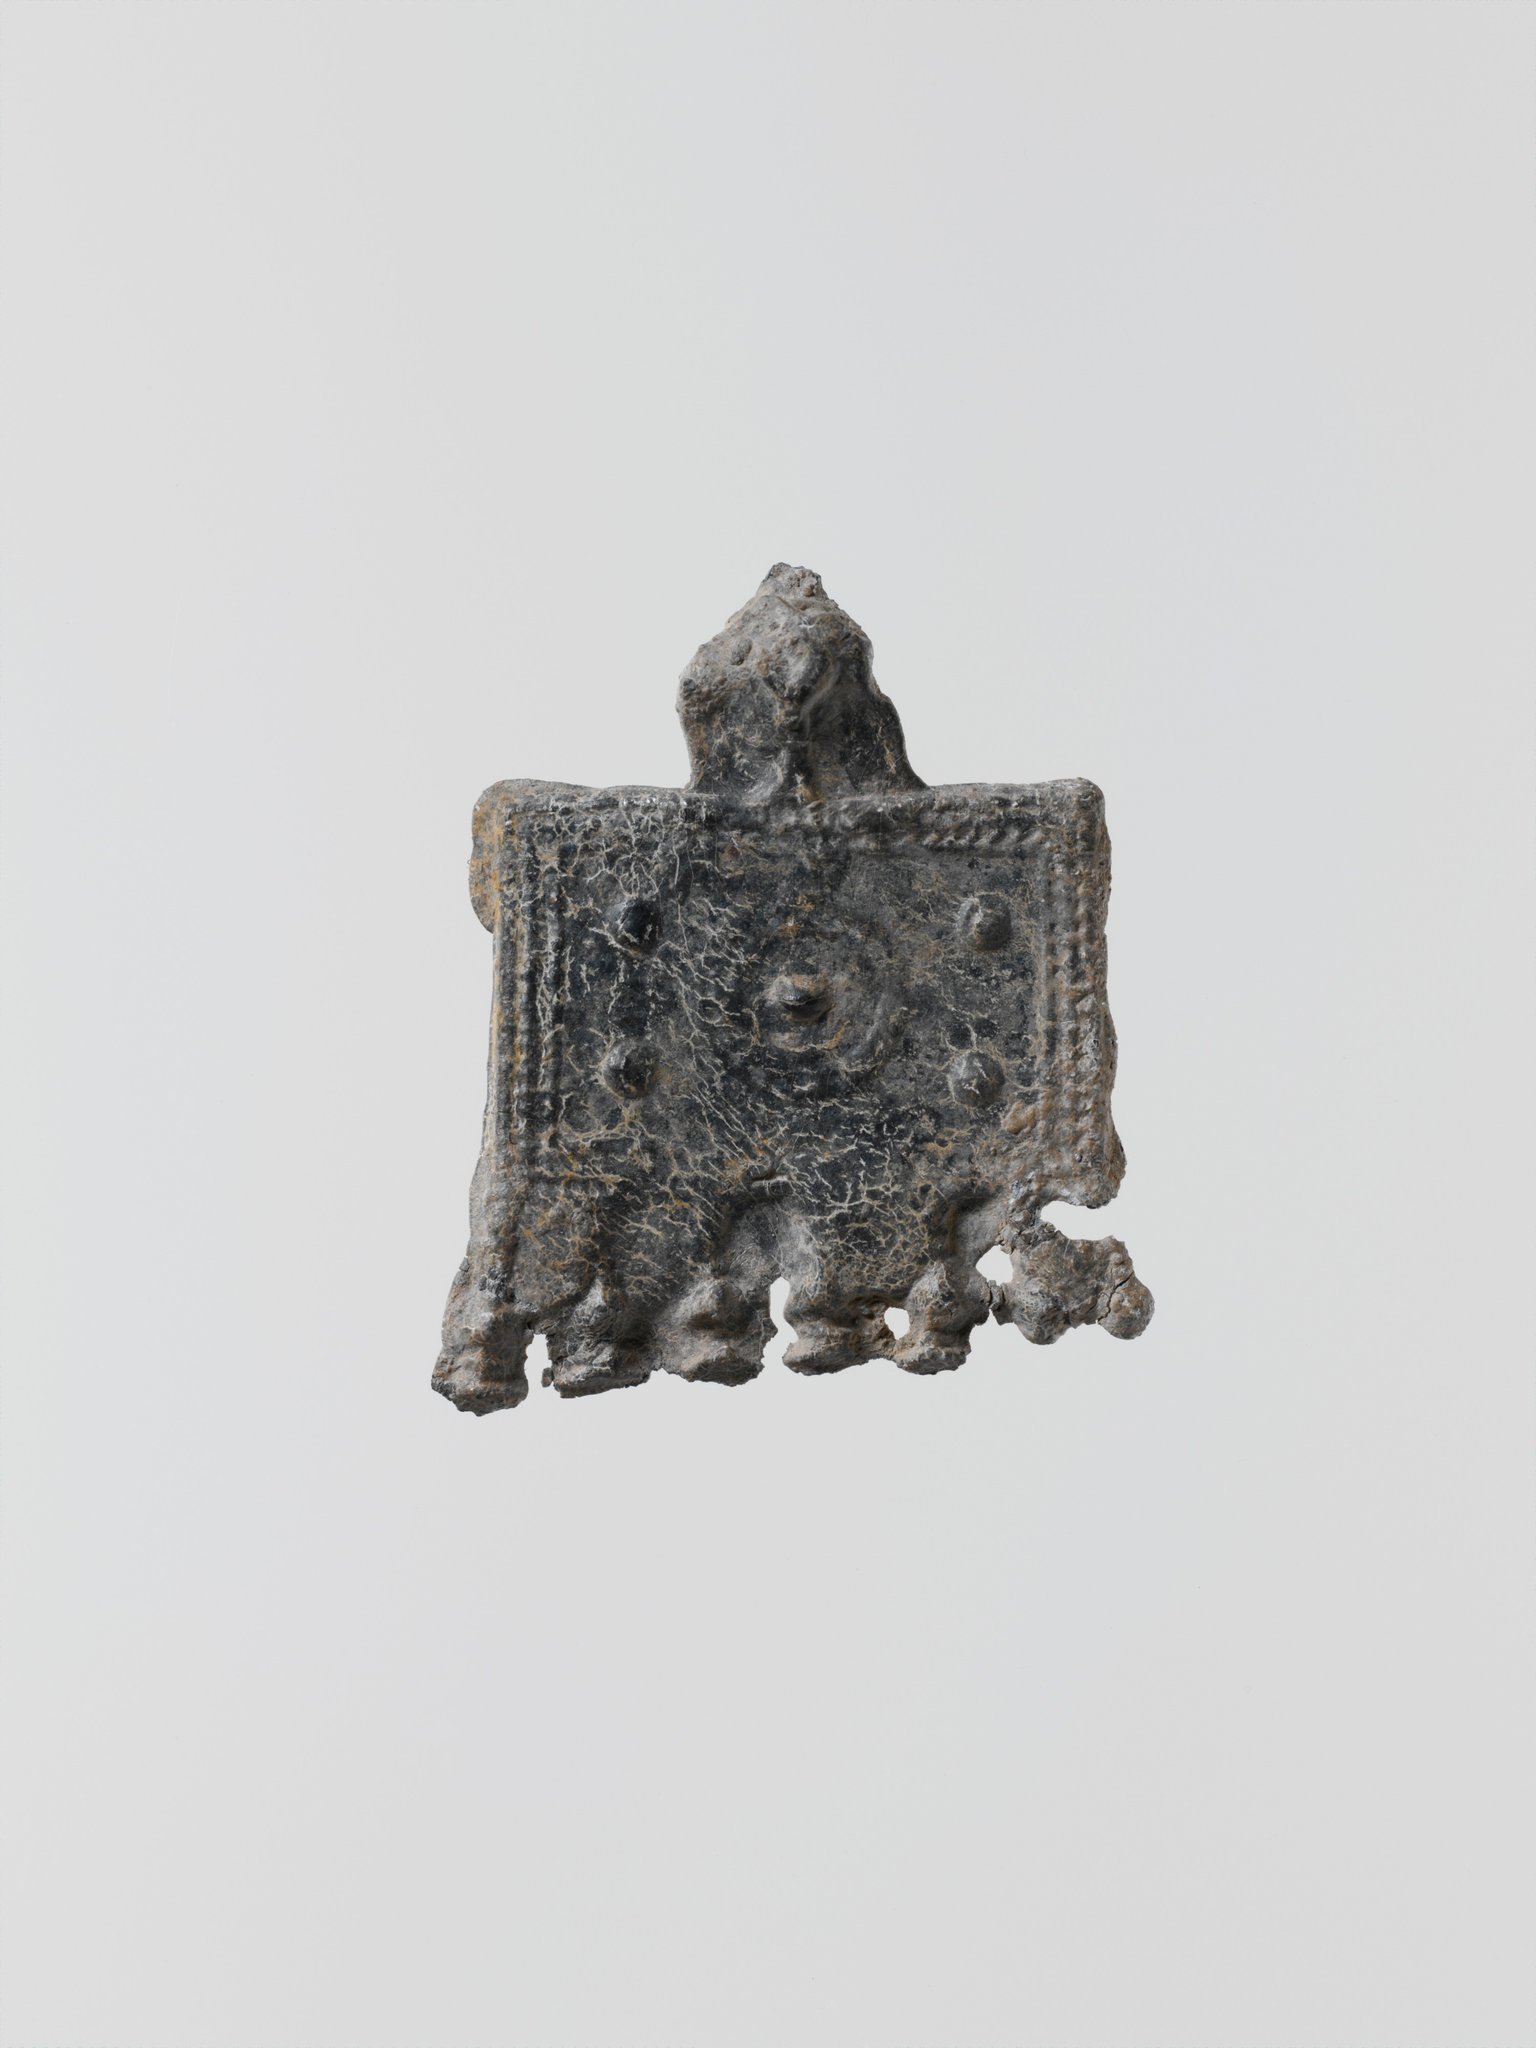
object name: ornament, 5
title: Lead ornament, possibly imitating jewelry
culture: greek, laconian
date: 600-401 BCE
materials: lead